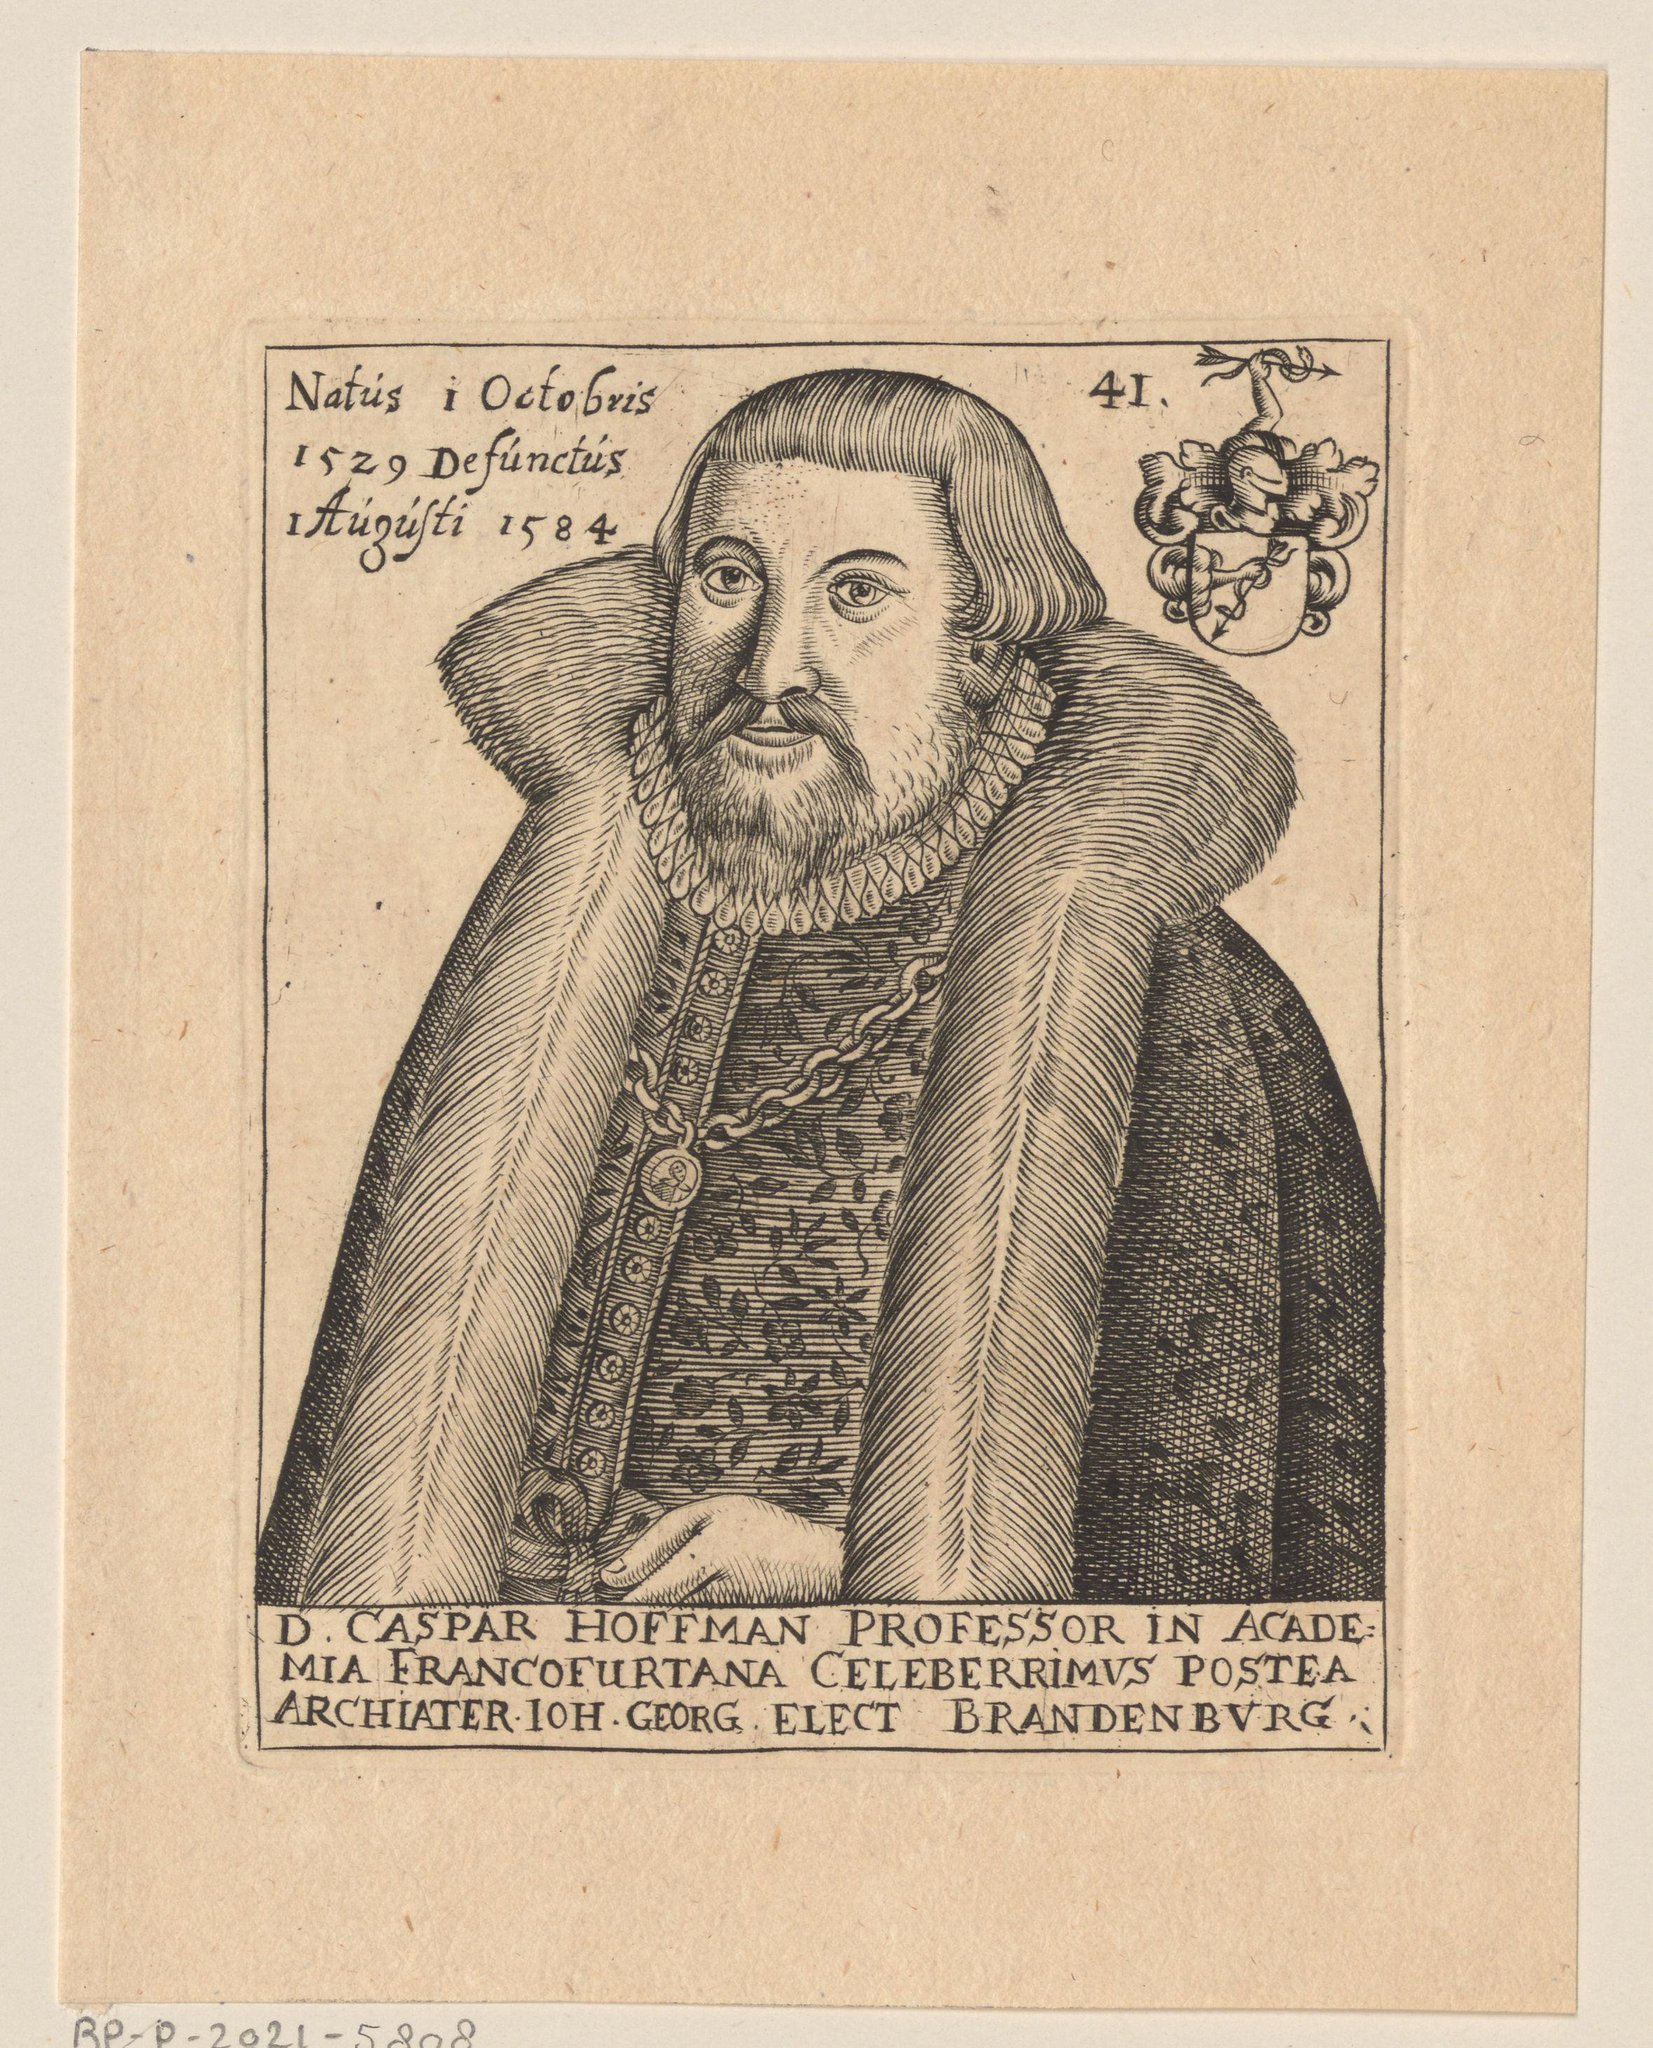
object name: print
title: Portret van Caspar Hoffmann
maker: Anonymous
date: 1751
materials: paper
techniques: engraving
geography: berlin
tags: historical persons, physician, doctor, armorial bearing, heraldry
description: Prent uit: Küster, Georg Gottfried. Martin Friedrich Seidels Bilder-Sammlung (...). Berlijn: Buchladens bey der Real-schule, 1751.